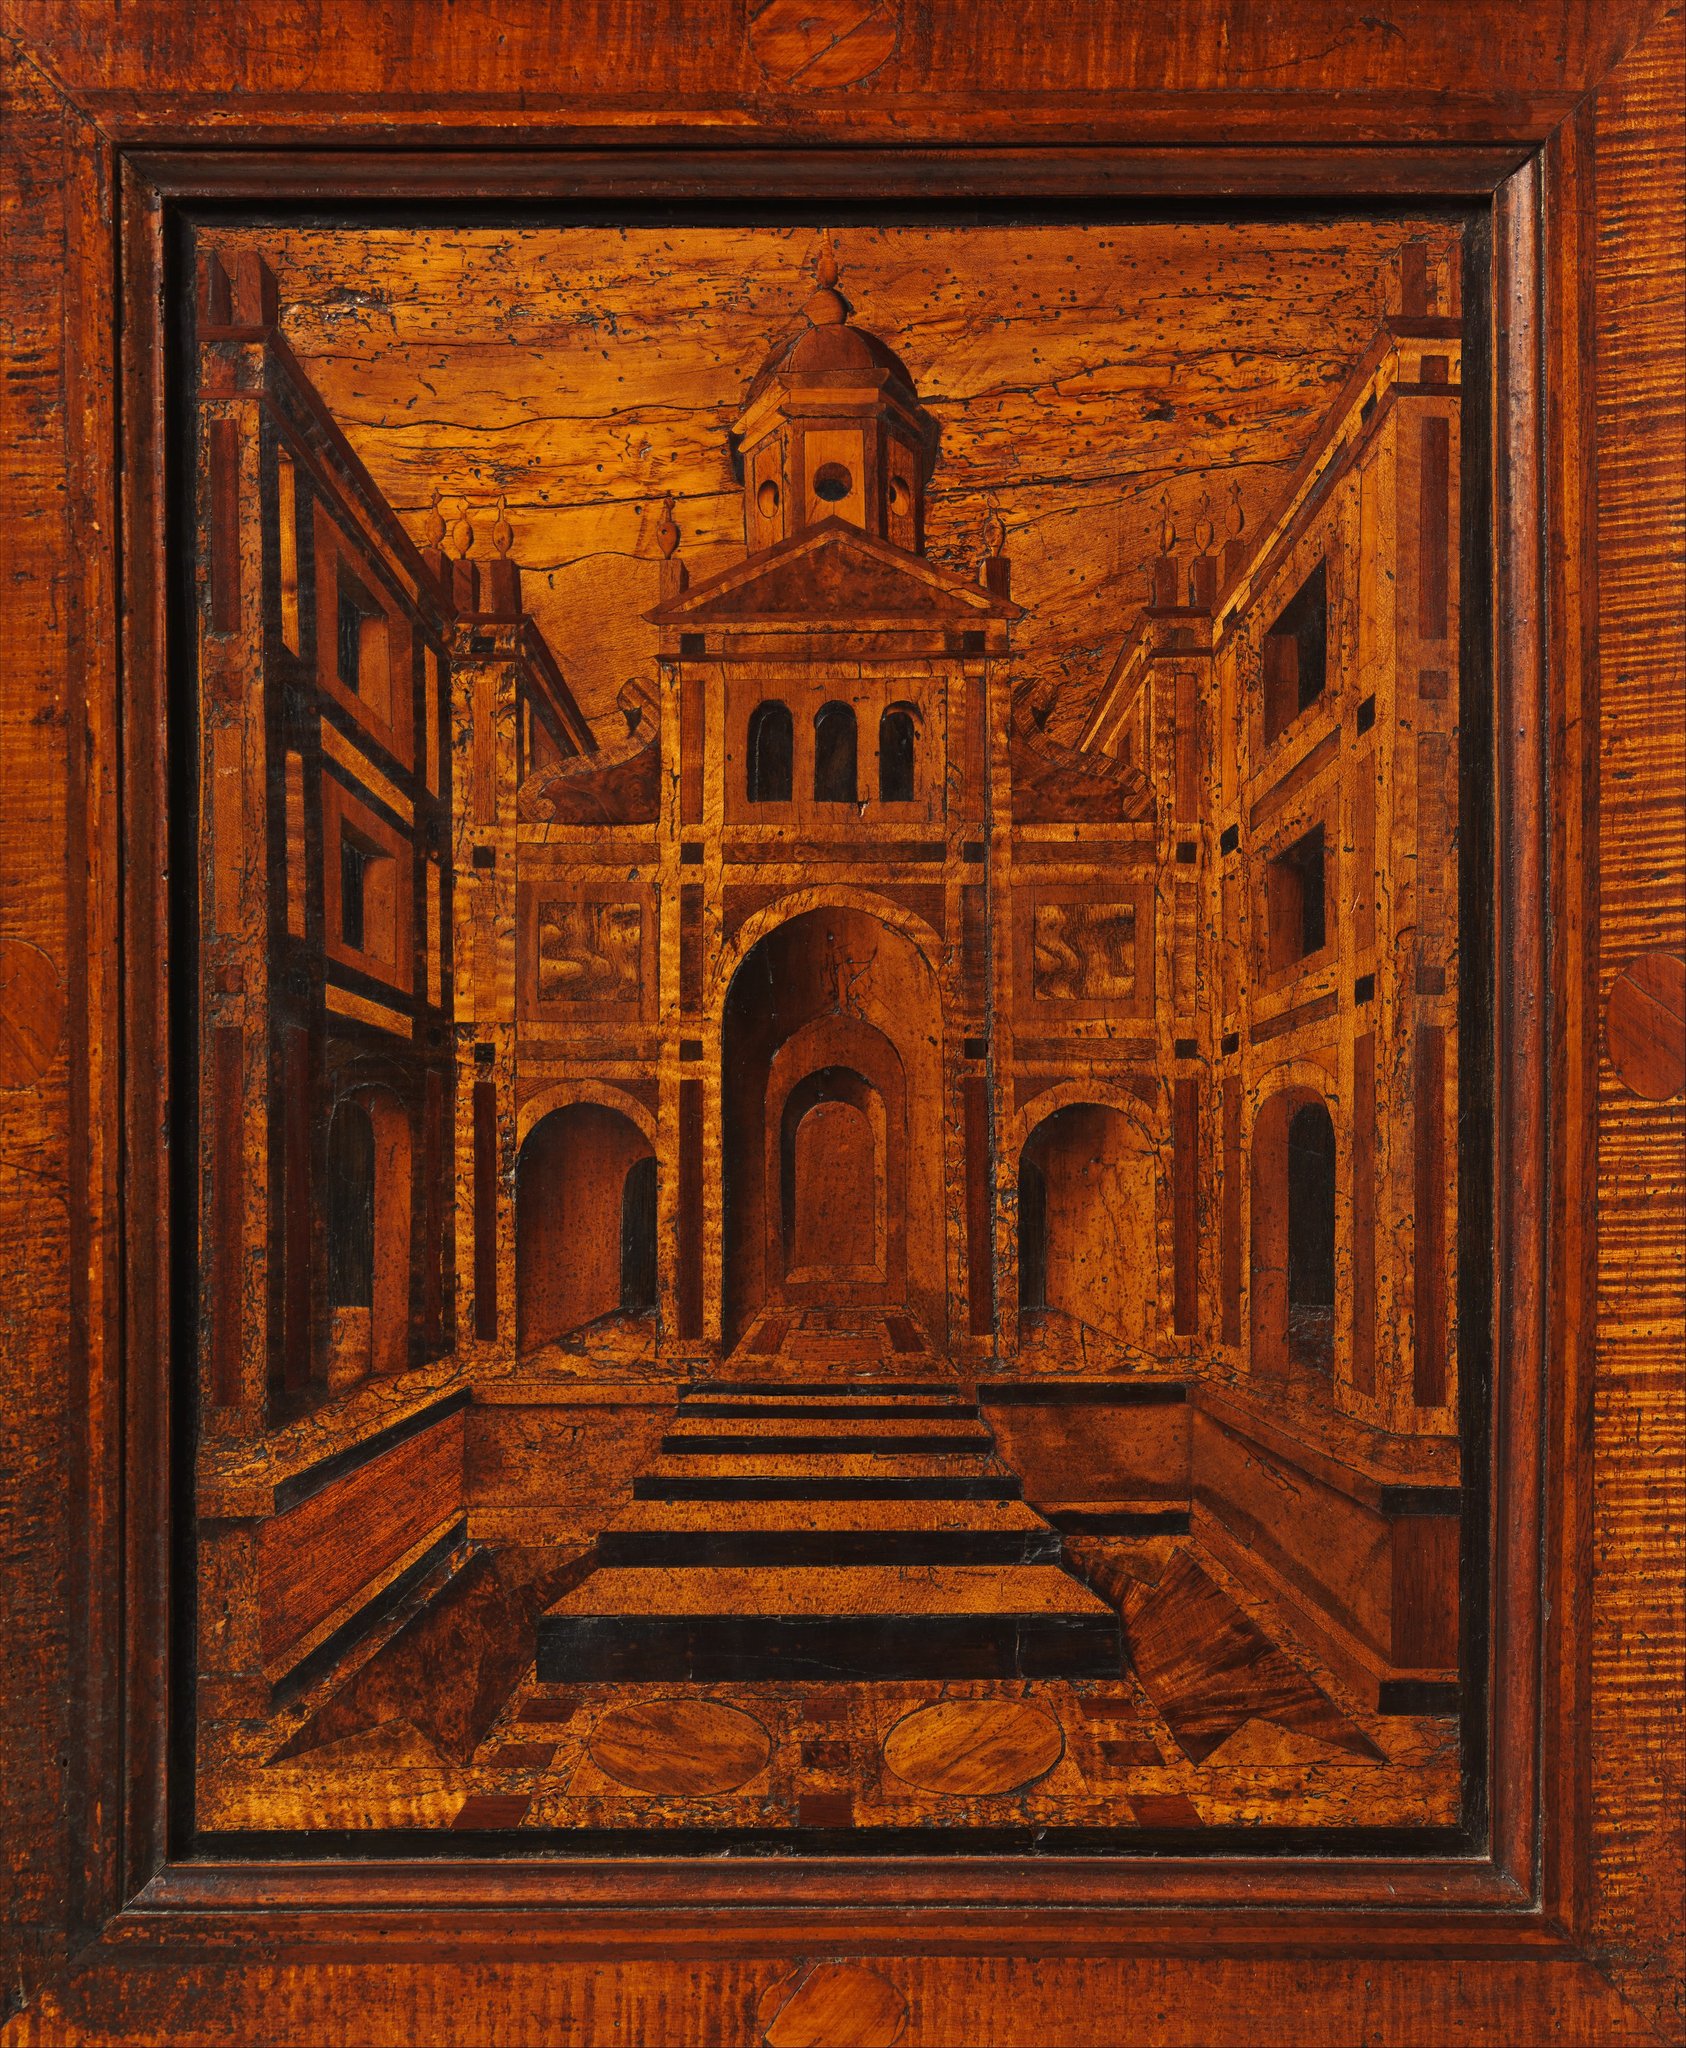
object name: panel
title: Architectural Capriccio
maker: francesco orlandini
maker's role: maker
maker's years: 1500-1600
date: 1547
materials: wood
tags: buildings